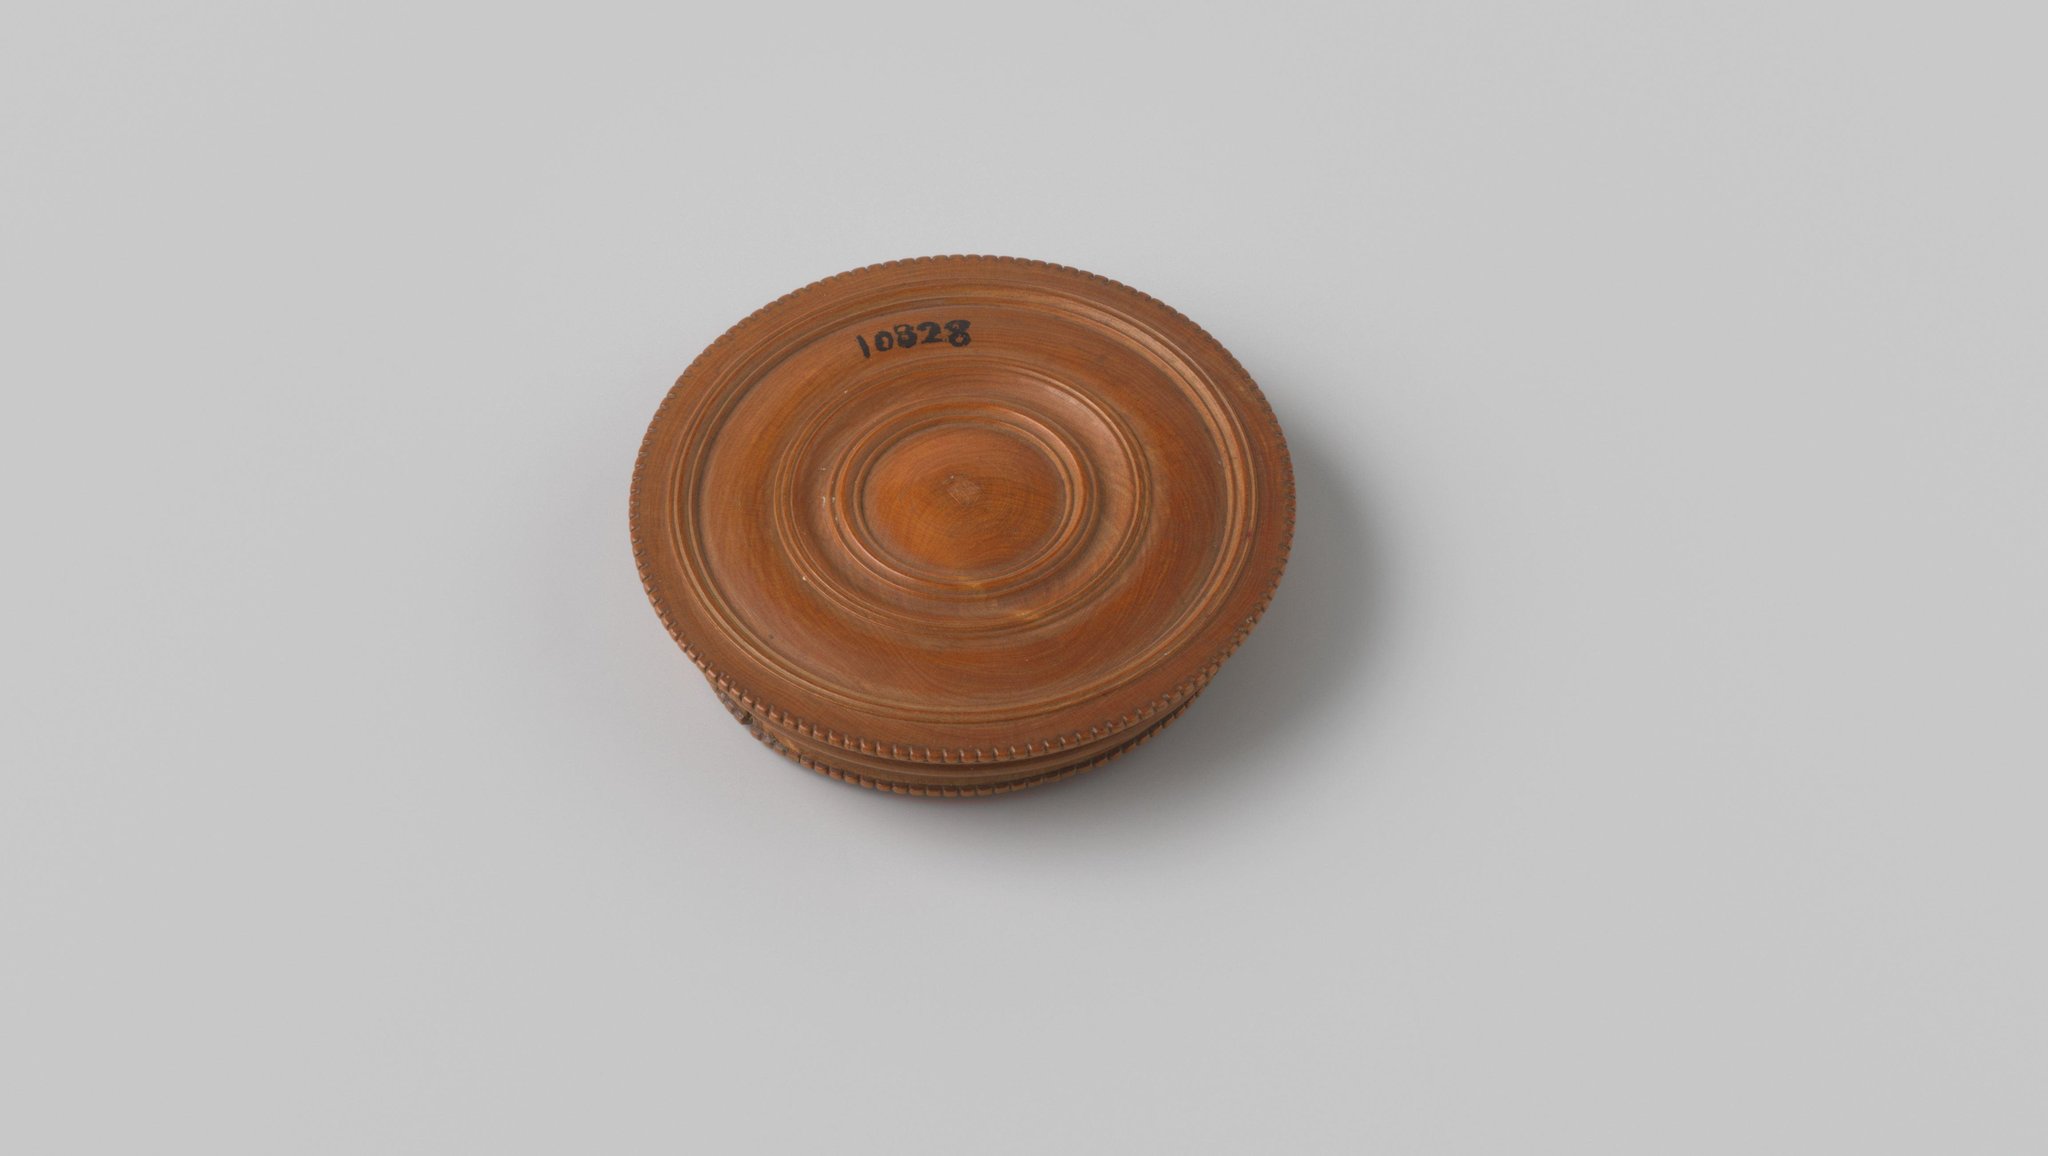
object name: medal box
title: Penningdoos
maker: Anonymous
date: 1808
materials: velvet, wood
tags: utrecht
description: Gedraaid houten doosje, met binnenkant van groen fluweel. Horend bij de penning BK-NM-10828-1.